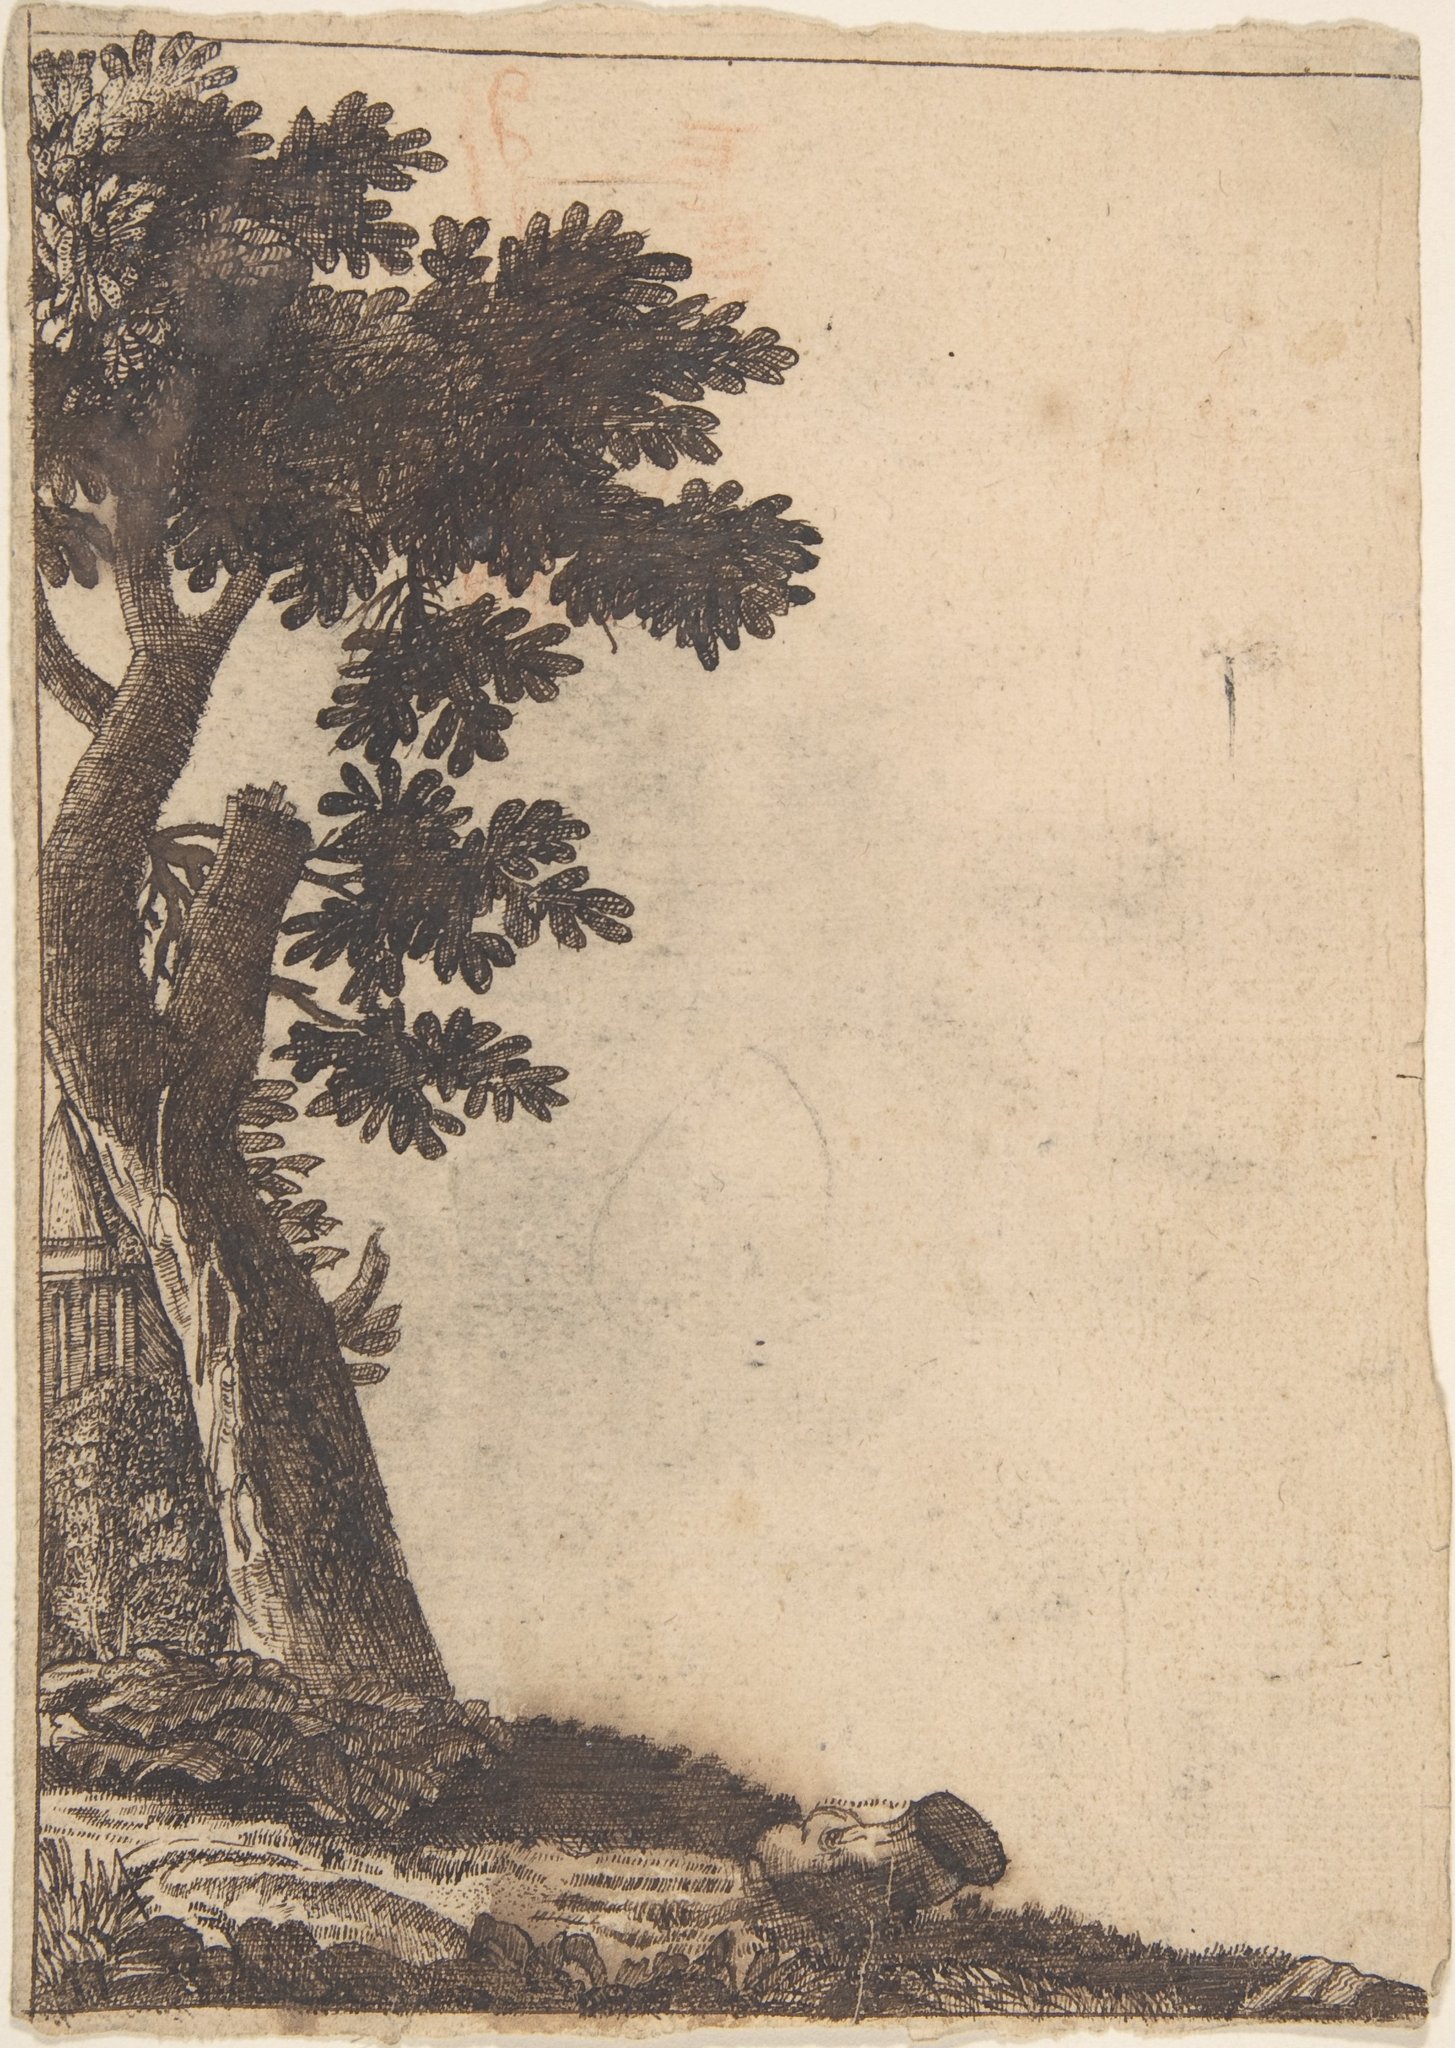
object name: drawing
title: Study of a Tree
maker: anonymous, netherlandish, 16th century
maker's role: artist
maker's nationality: netherlandish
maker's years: 1500-1600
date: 1501-1600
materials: ink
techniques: pen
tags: trees